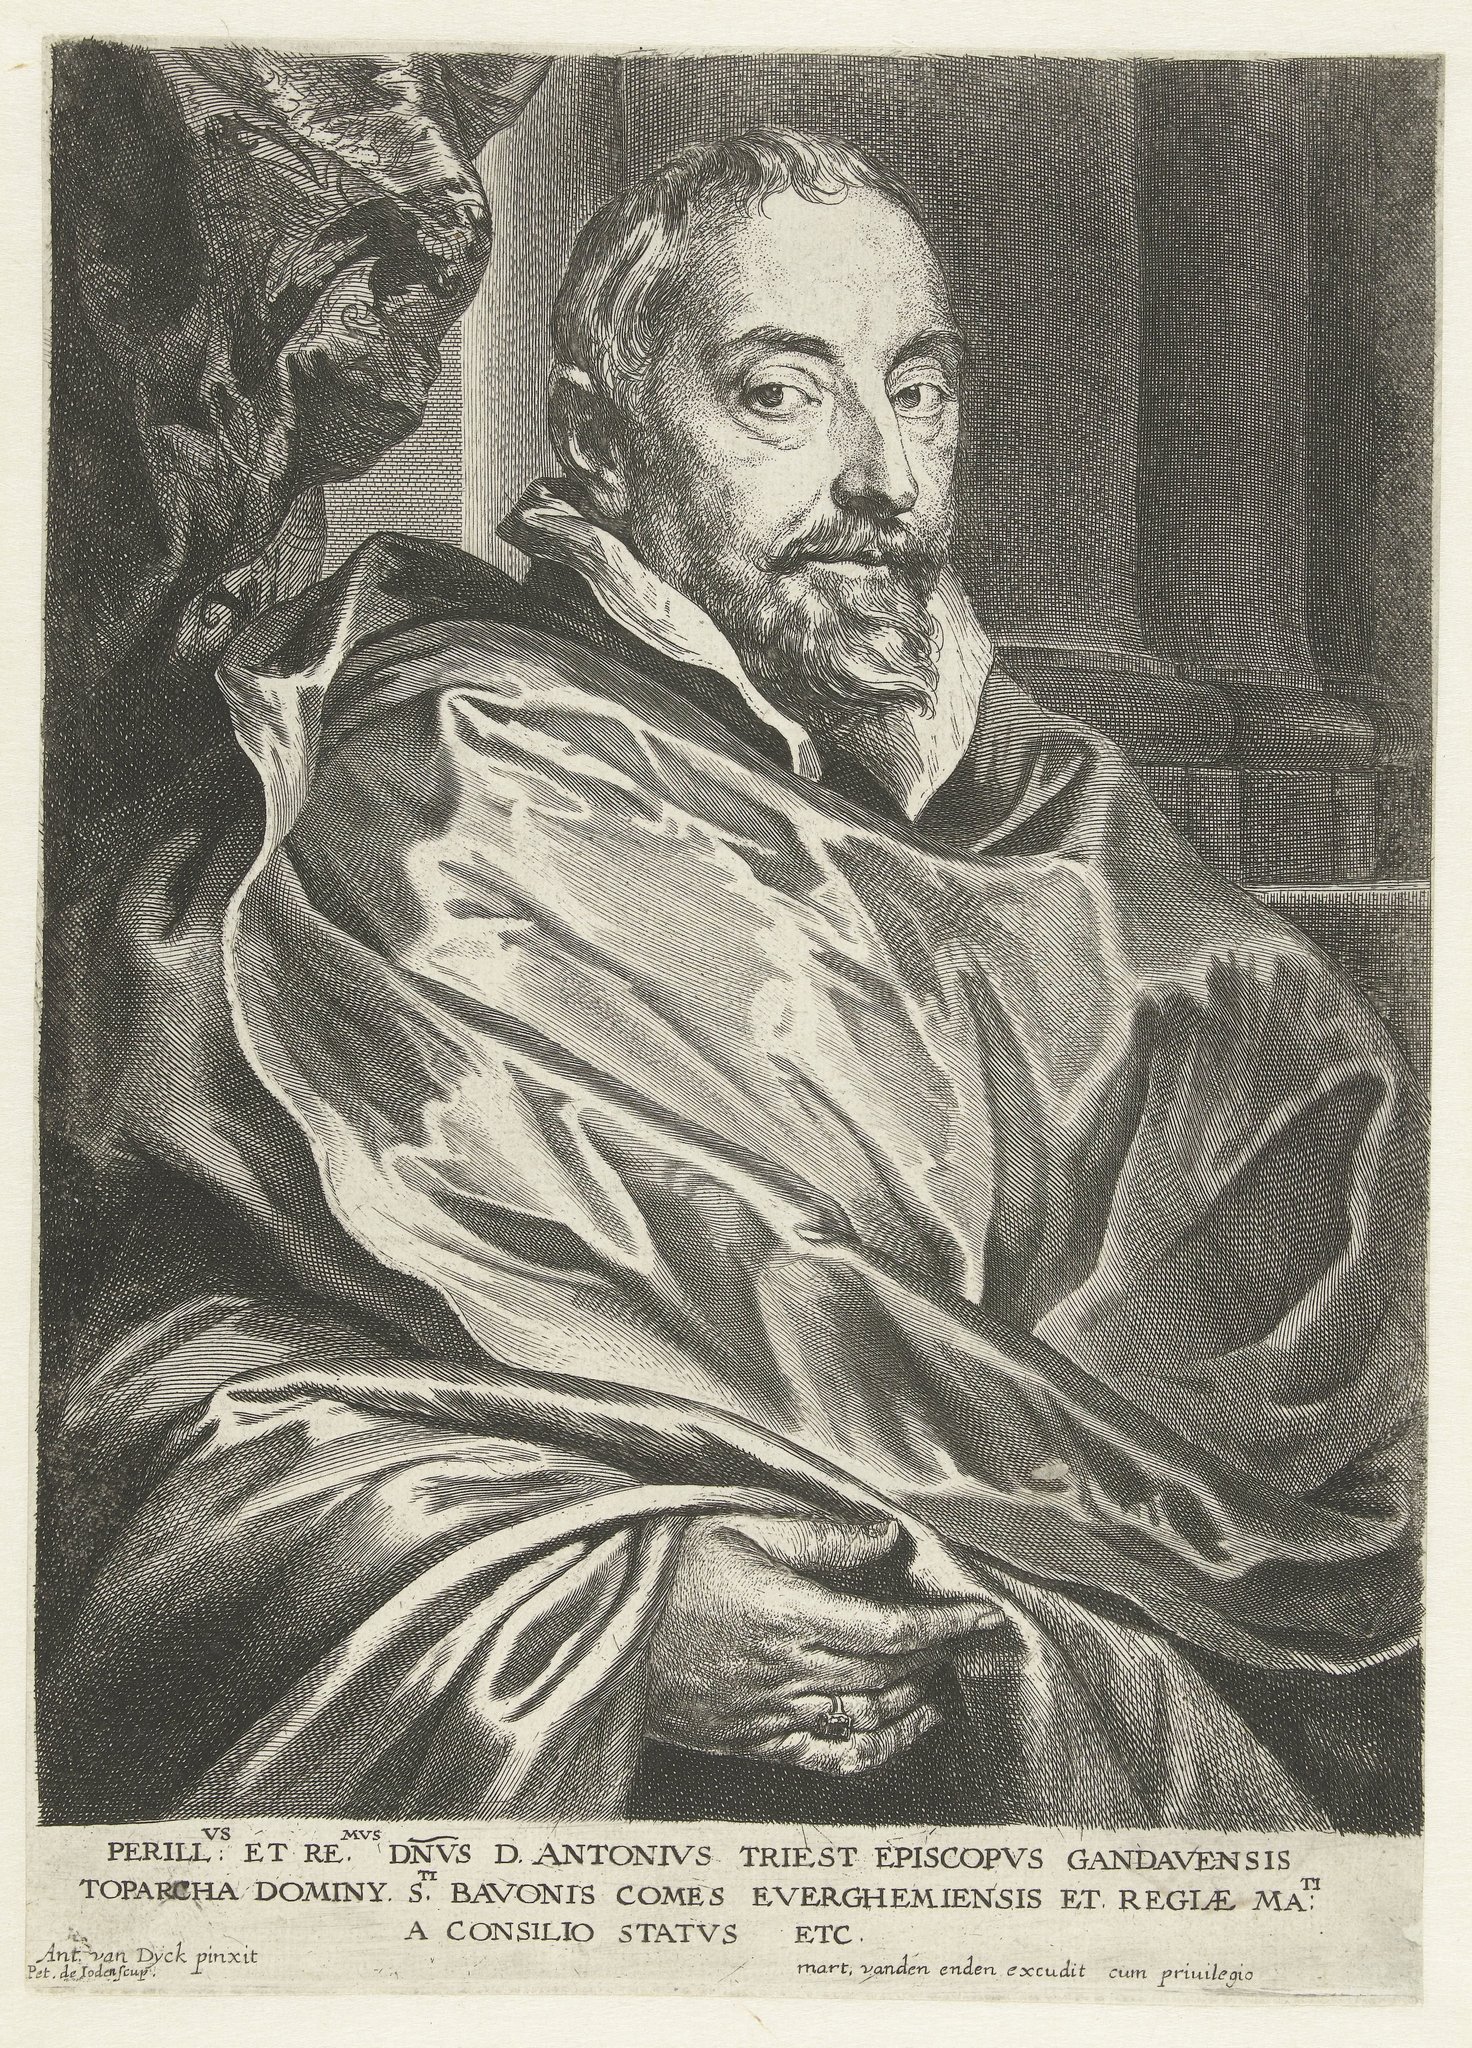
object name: print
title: Iconographie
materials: paper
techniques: engraving, etching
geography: low countries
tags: ghent, antonius triest, archbishop, bishop, etc. (roman catholic)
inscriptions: collector's mark: Lugt 240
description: Portret van Antonius Triest, bisschop van Gent, met latijns onderschrift PERILL VS ET RE. MUS ... CONSILIO STATVS ETC.